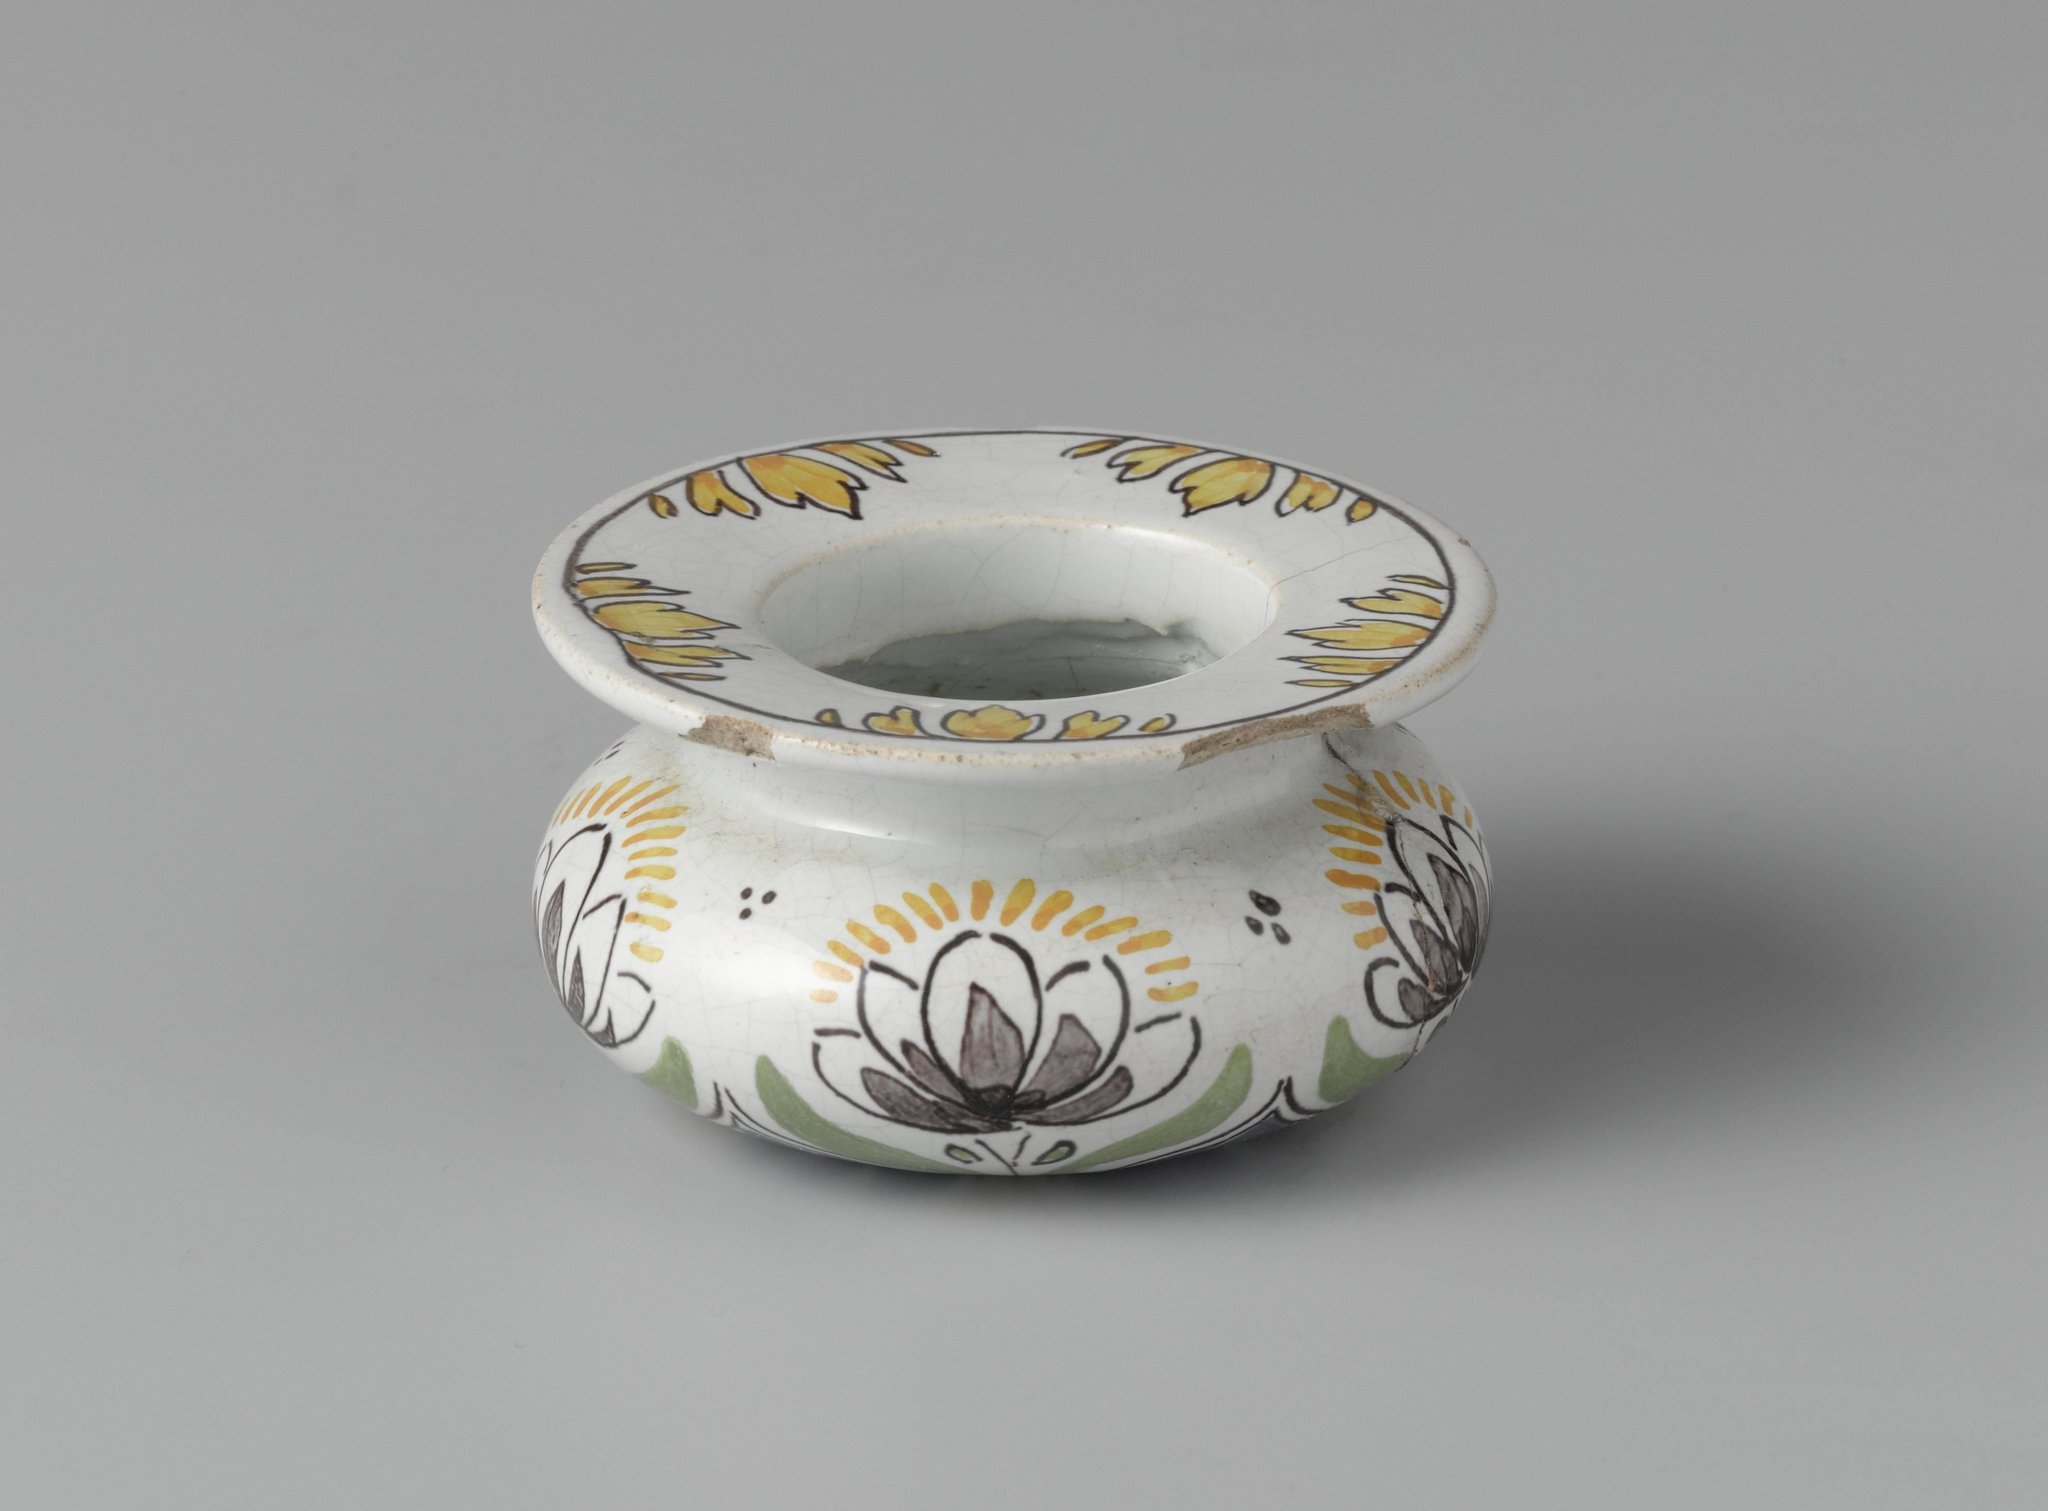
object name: vase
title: Vaas met bolvormig lichaam, kort ingesnoerde hals en wijd uitstaande mondrand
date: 1880-1920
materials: earthenware, glaze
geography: delft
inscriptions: mark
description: Vaas van aardewerk, met bol lichaam en kort ingesnoerde hals en wijd uitstaande mondrand. Gedecoreerd met gestileerde bloemen en bladwerk in de kleuren blauw, groen, zwart en geel.